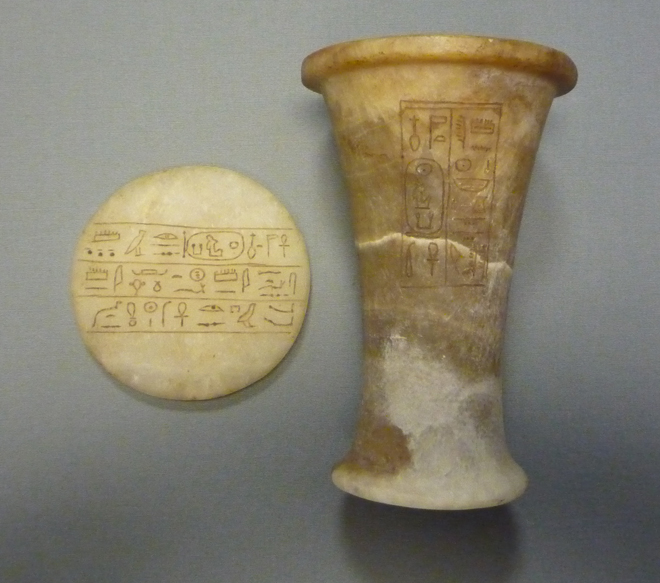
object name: ointment jar, foundation deposit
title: Ointment Jar from a Foundation Deposit of Hatshepsut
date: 1479-1458 BCE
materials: paint, stone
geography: egypt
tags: hieroglyphs